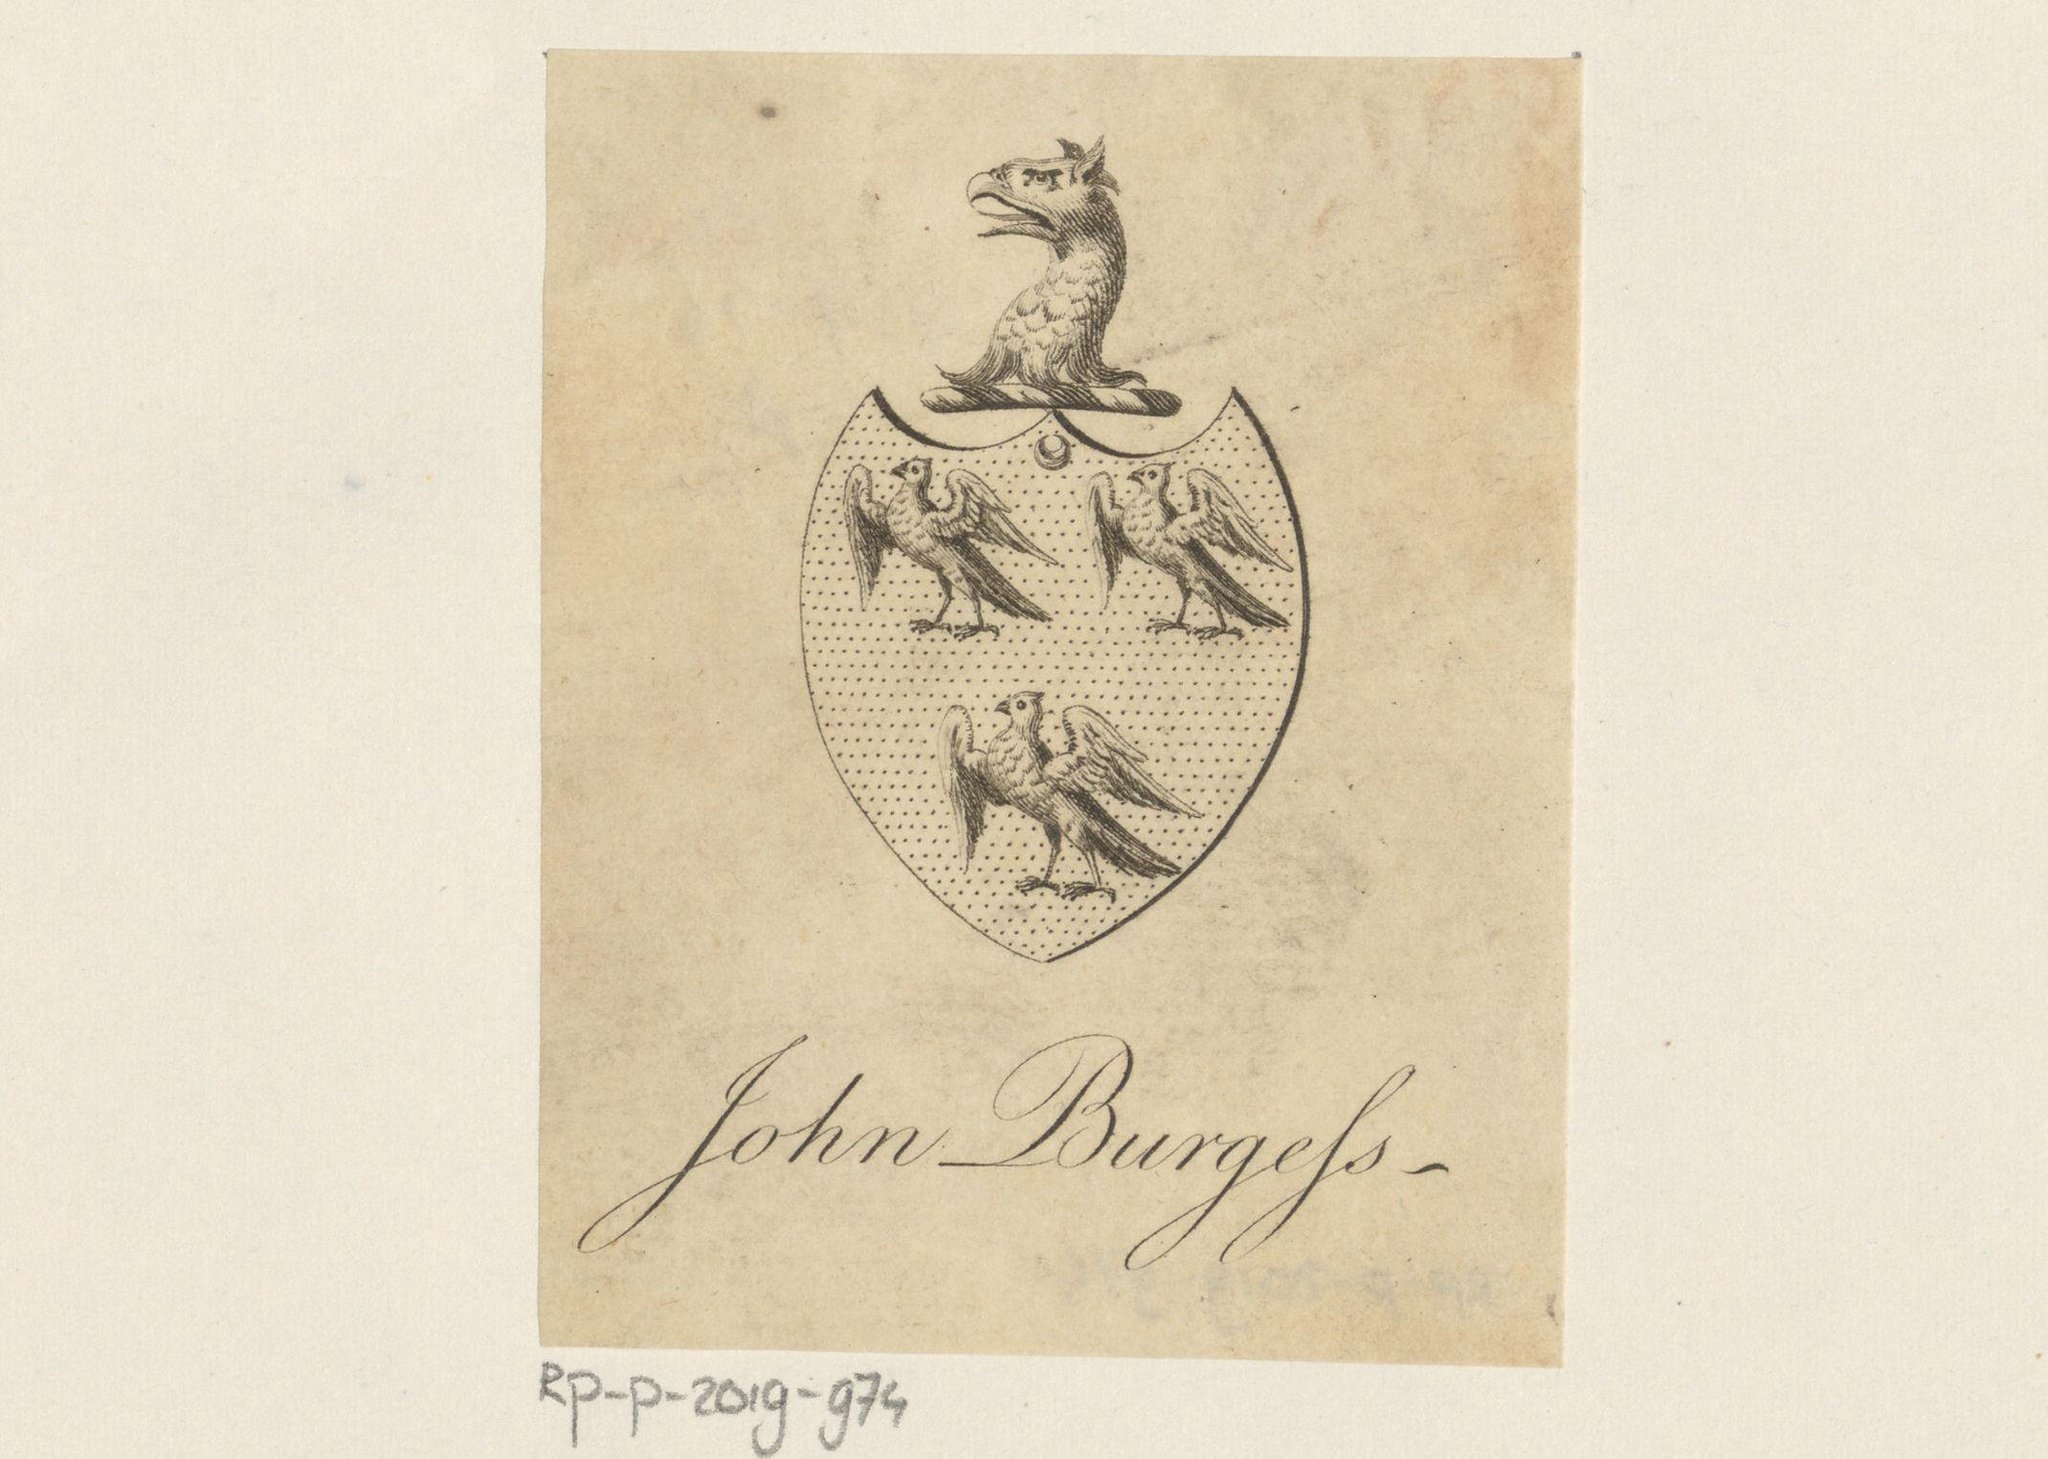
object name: bookplate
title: Ex libris van John Burgess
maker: Anonymous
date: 1800-1899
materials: paper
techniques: engraving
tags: armorial bearing, heraldry